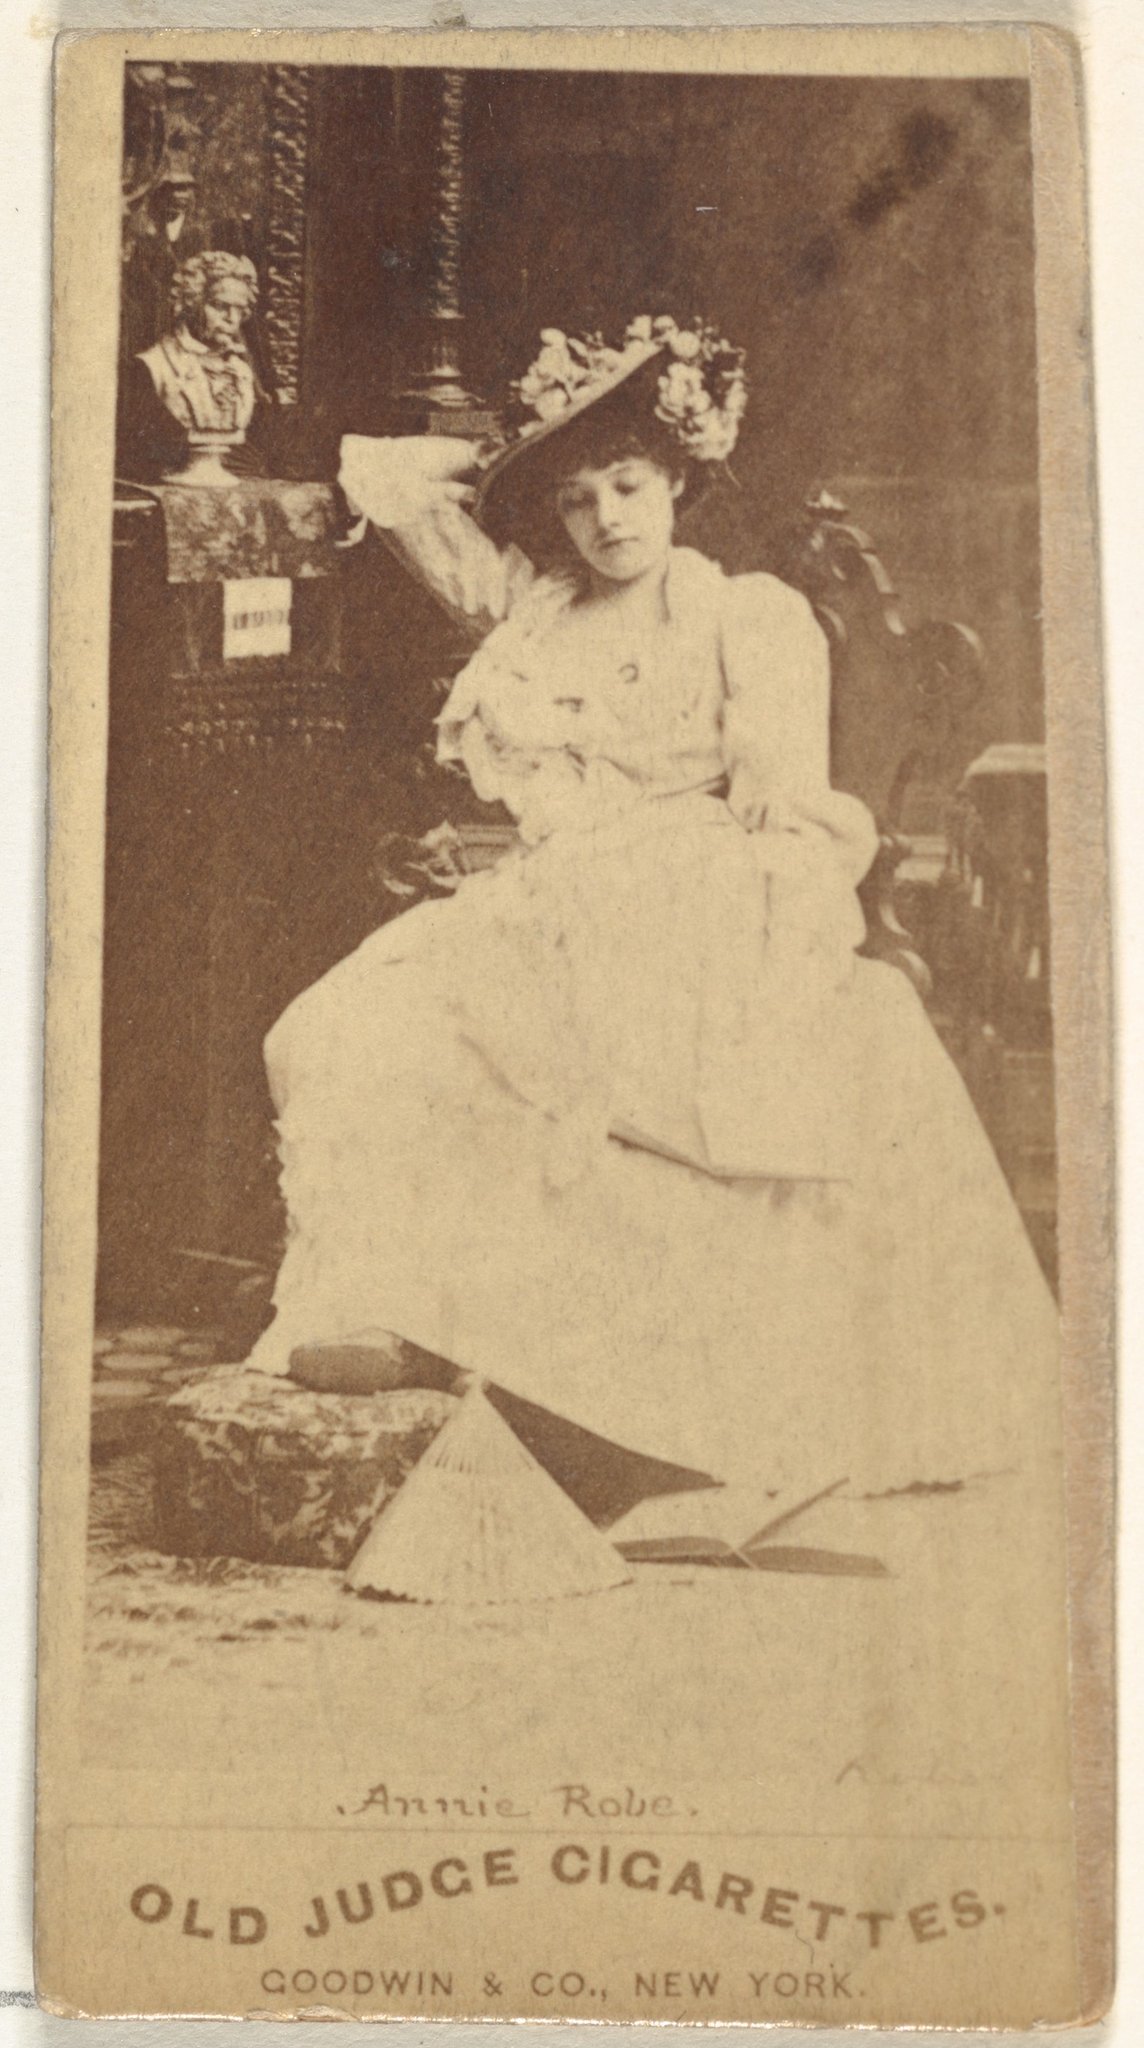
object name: photograph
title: Annie Robe, from the Actors and Actresses series (N171) for Old Judge Cigarettes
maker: goodwin & company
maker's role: publisher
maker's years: 1850-1950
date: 1886-1890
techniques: albumen silver print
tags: women,actresses